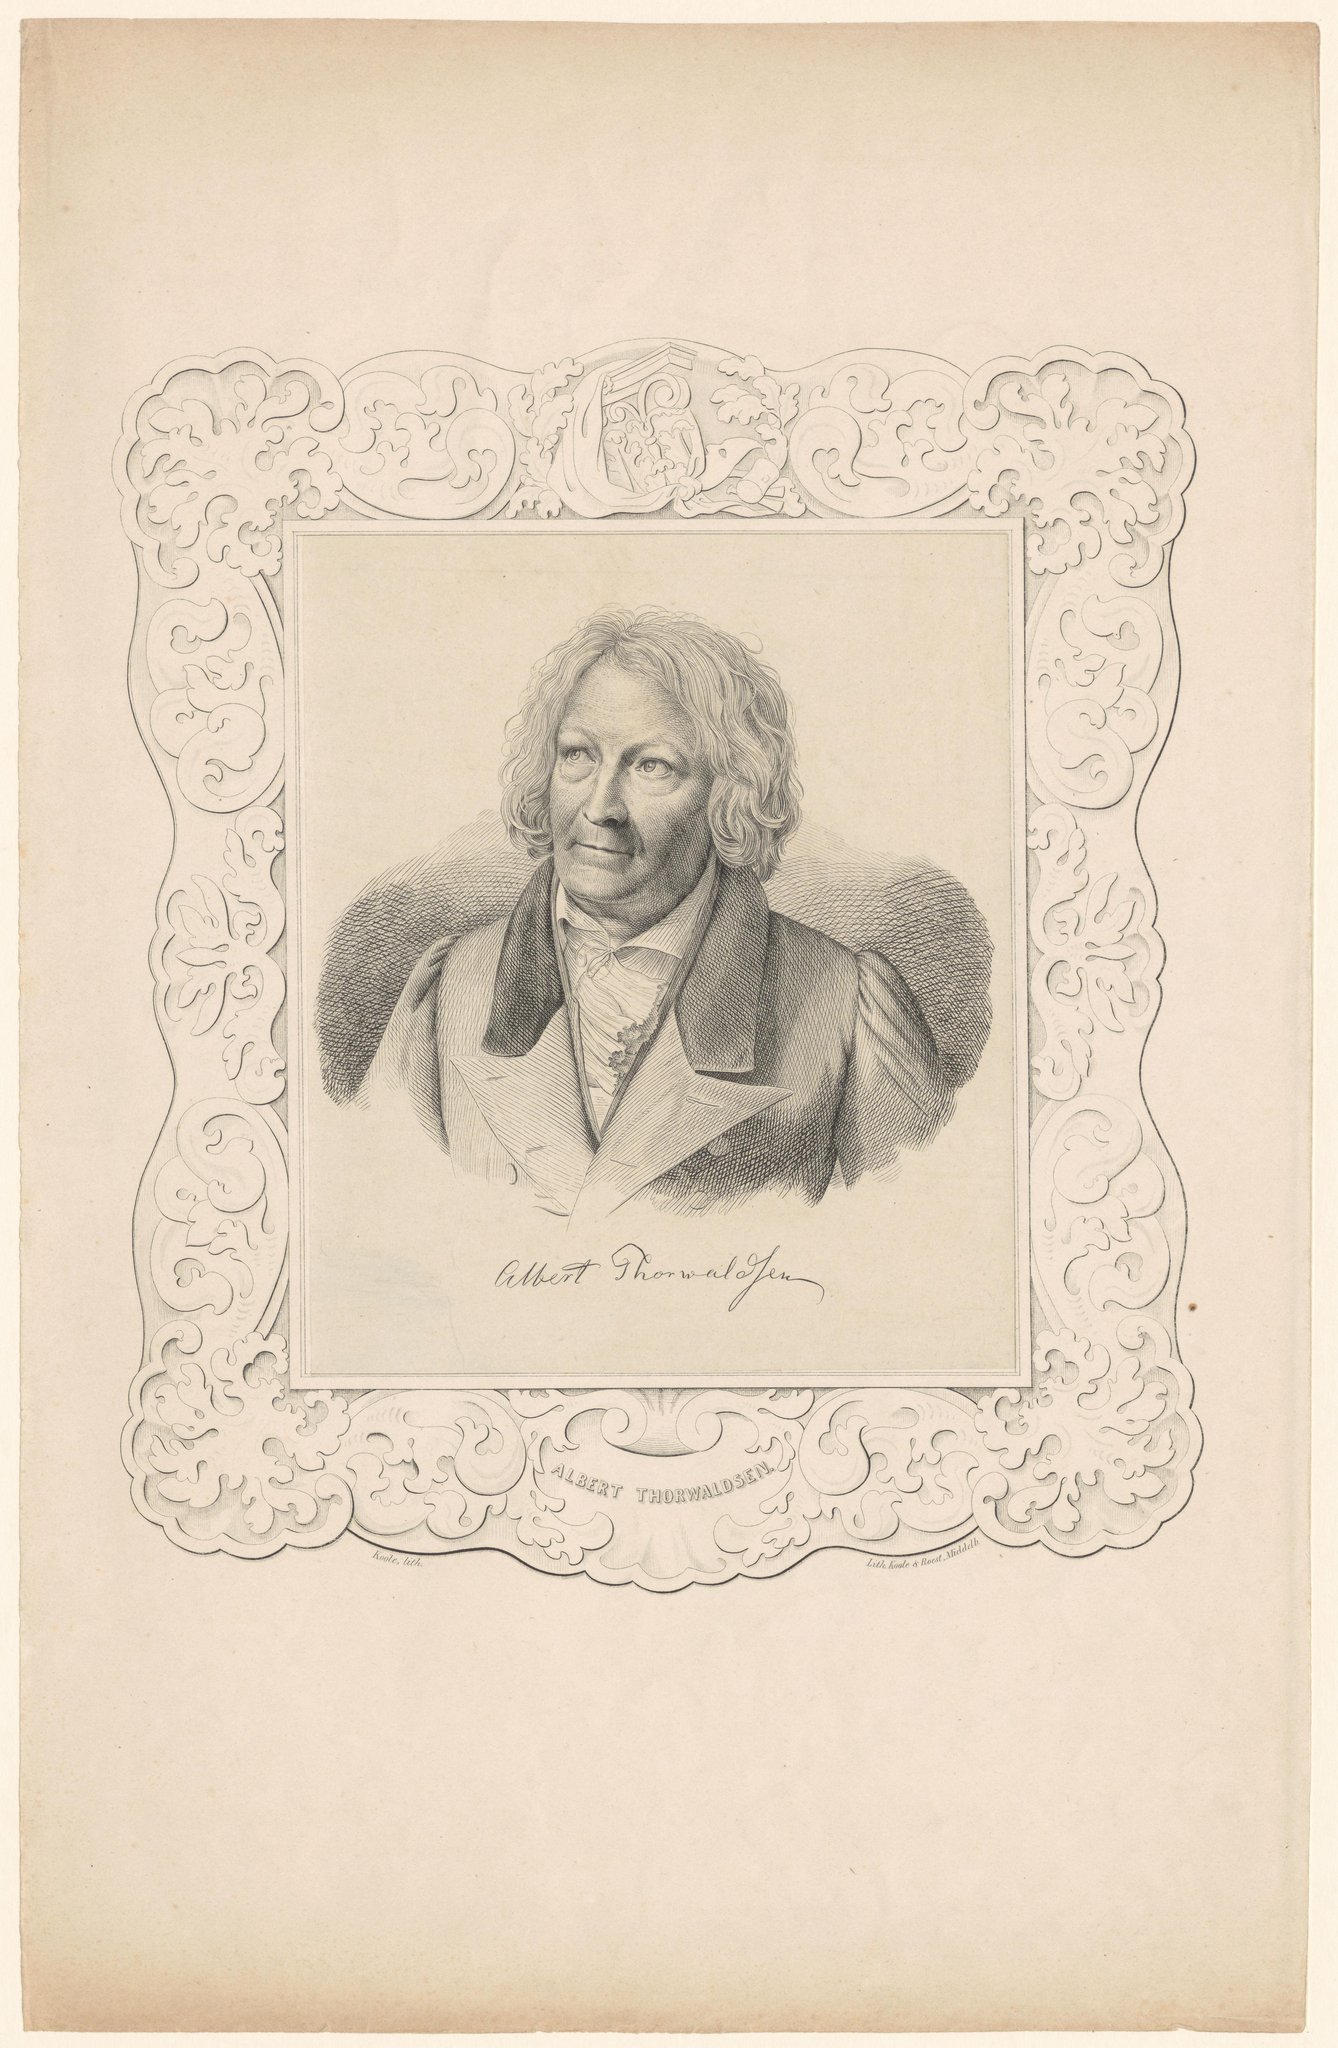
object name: print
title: Portret van Bertel Thorvaldsen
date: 1839-1841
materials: paper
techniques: etching, lithograph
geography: middelburg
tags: copenhagen (city), draughtsman, bertel thorvaldsen, portrait, self-portrait of sculptor, historical persons, frame of painting, etc.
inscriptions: collector's mark: Lugt 2228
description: Een ornamentrand om het portret en de facsimile signatuur.